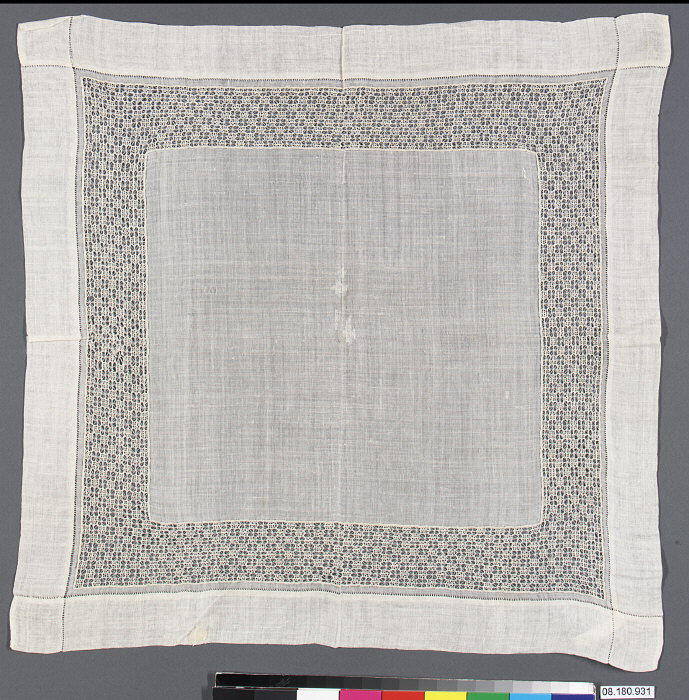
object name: handkerchief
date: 1801-1900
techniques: embroidery